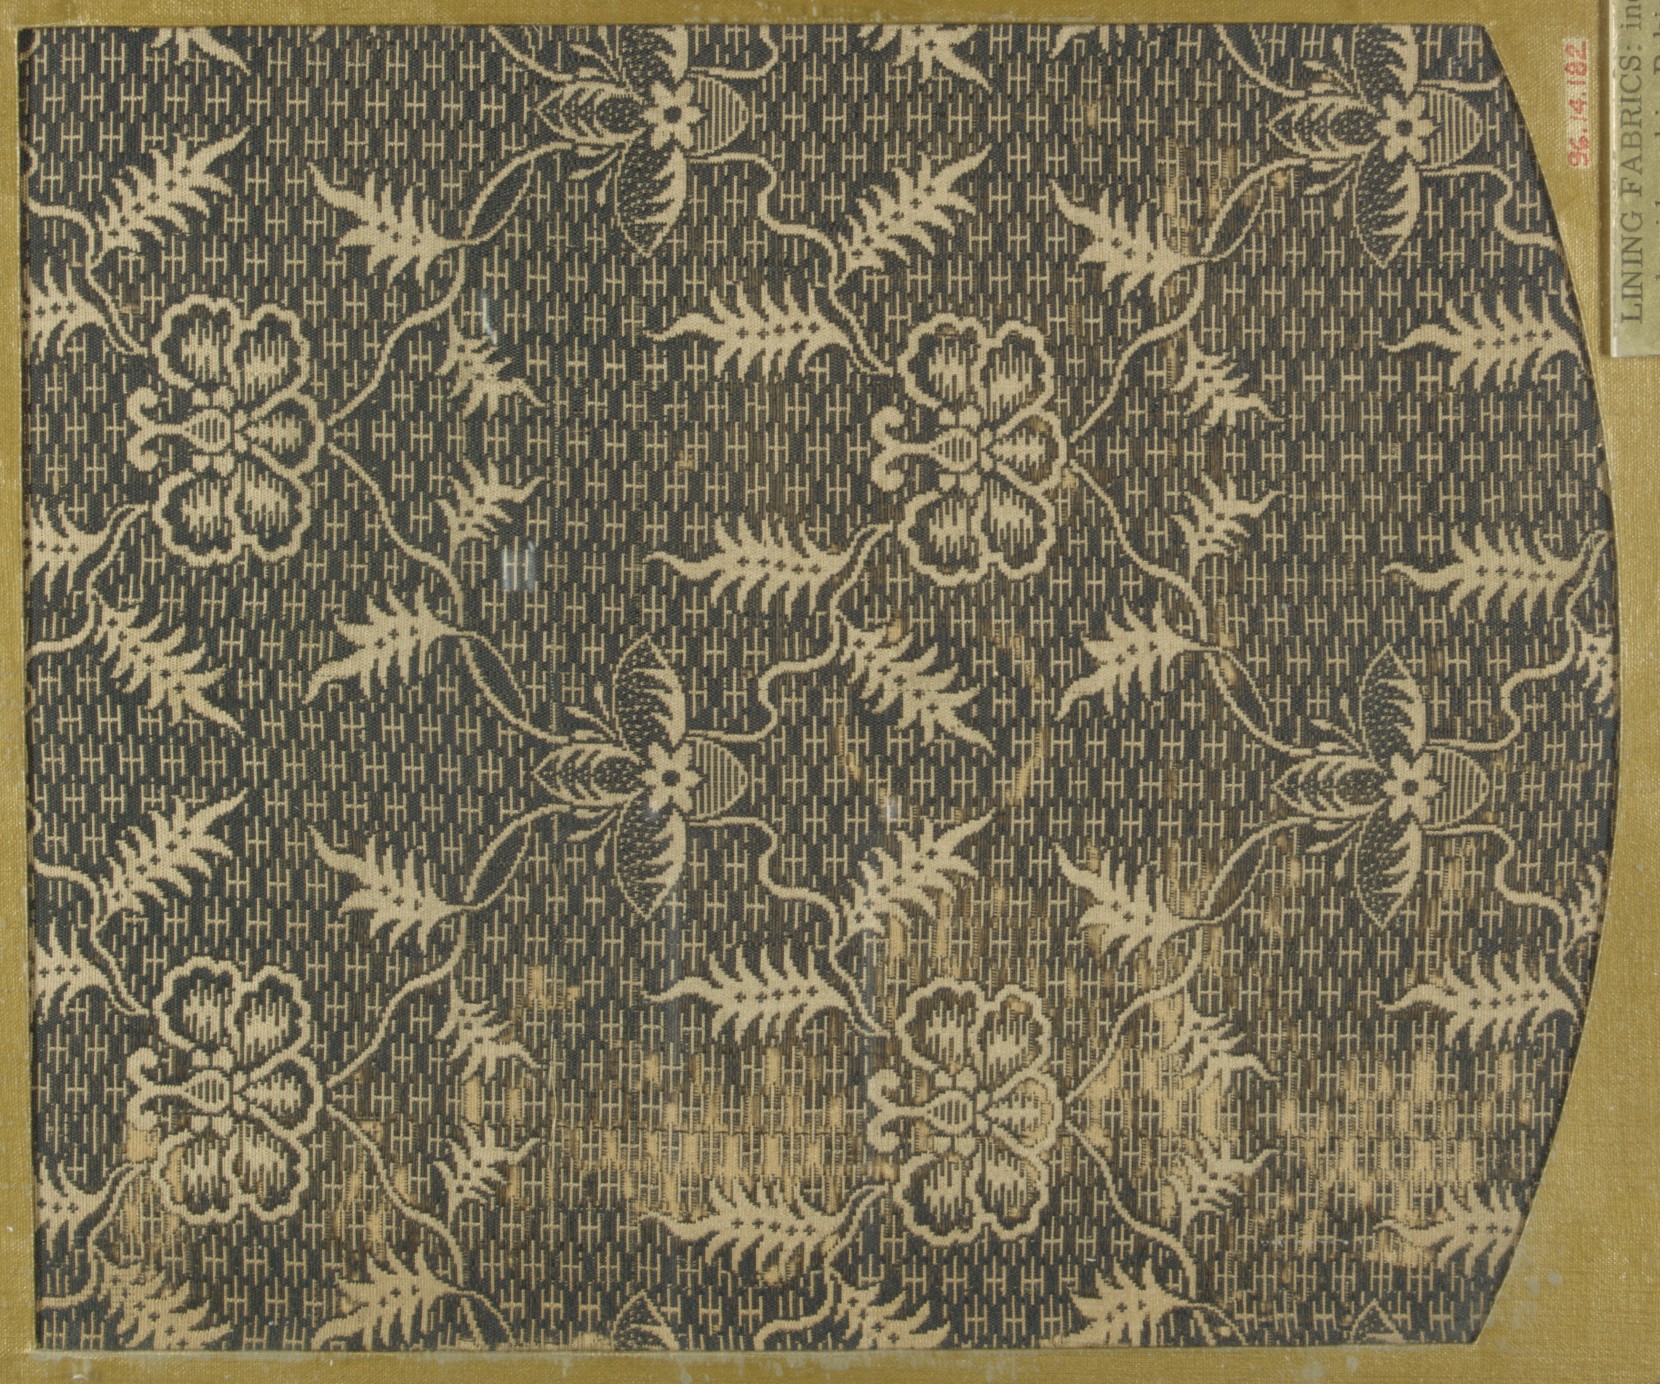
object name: fragment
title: Textile fragment with repeating floral pattern on geometric diaper ground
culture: japanese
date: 1701-1900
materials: silk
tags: leaves